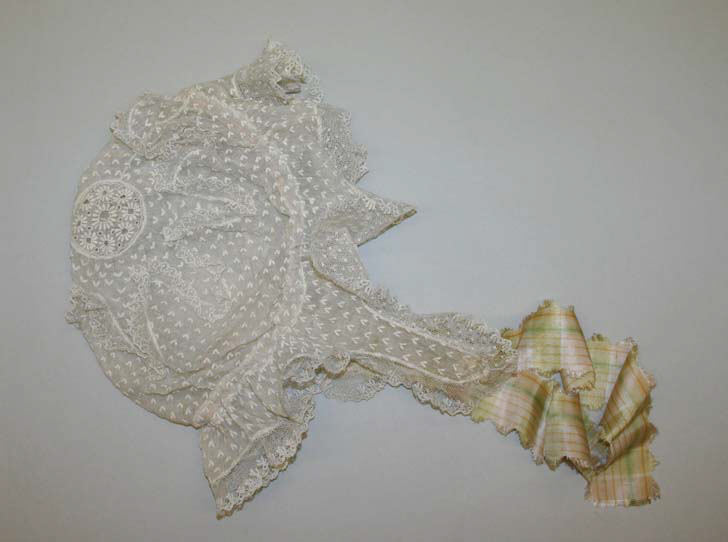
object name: cap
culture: american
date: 1834-1866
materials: cotton